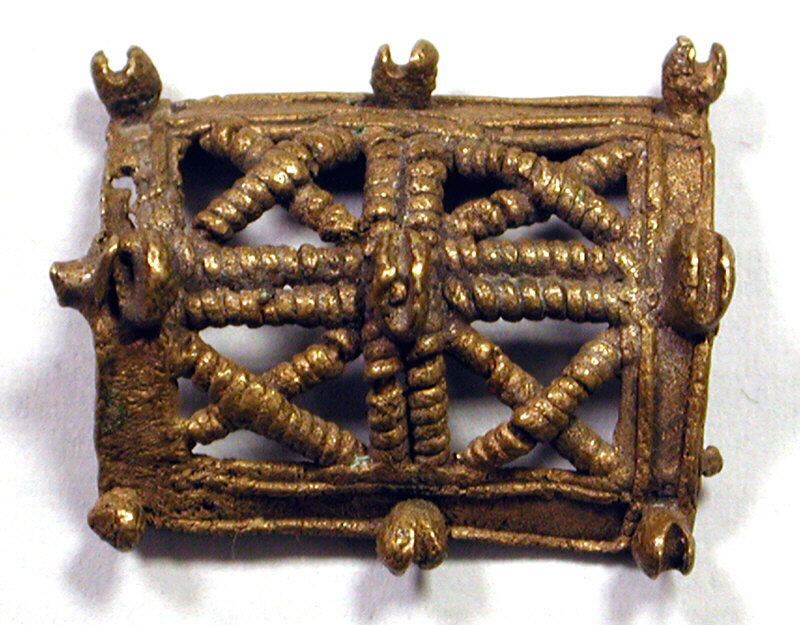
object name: weight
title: Gold Weight: Shield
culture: akan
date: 1701-1900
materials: brass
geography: ghana